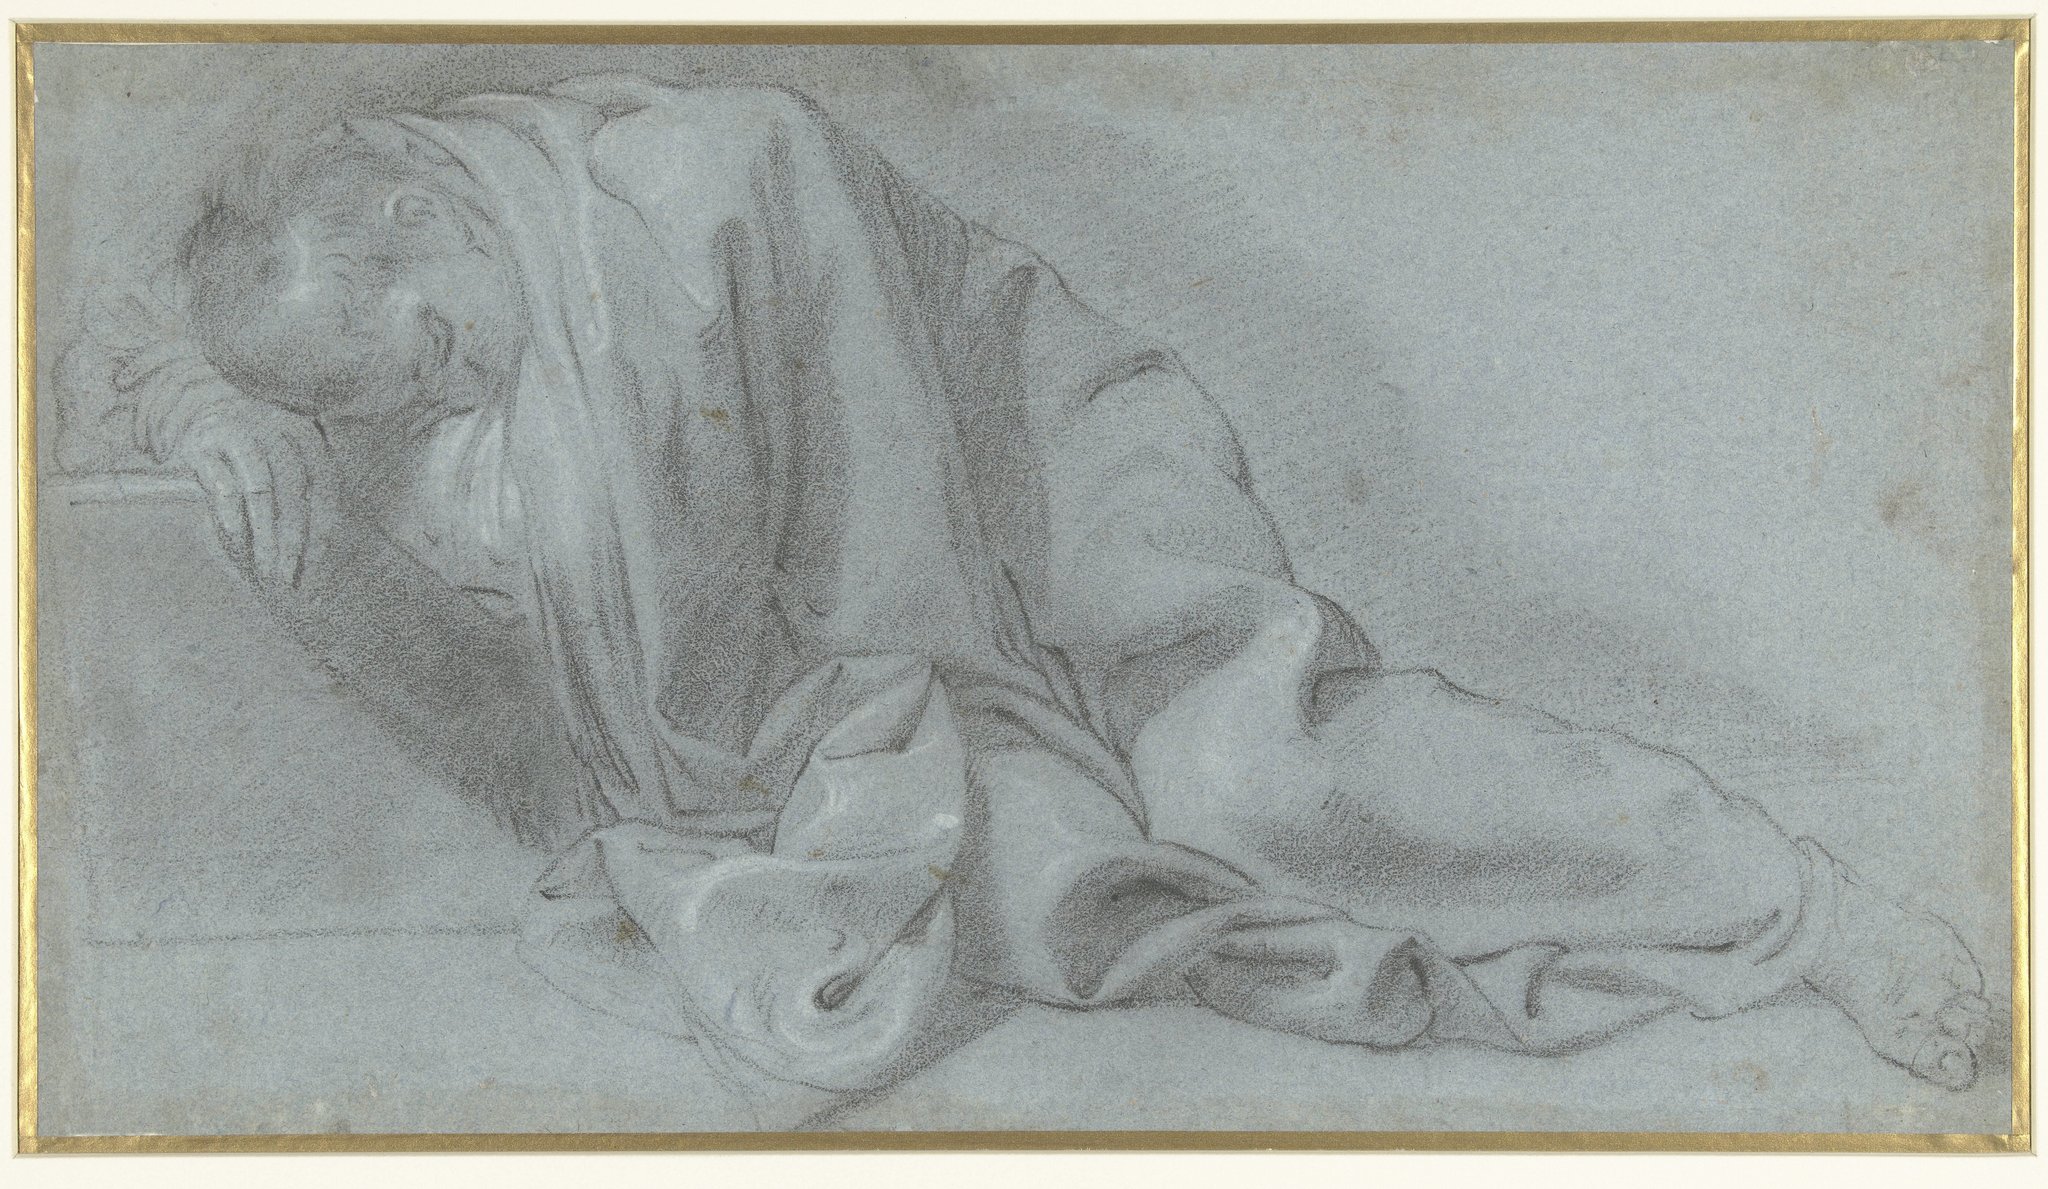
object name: drawing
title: Studie van een op de grond ingeslapen mannelijk model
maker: giacomo cavedone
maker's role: draughtsman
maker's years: 1577-1660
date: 1587-1660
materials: chalk, paper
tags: sleeping on the ground, lying figure